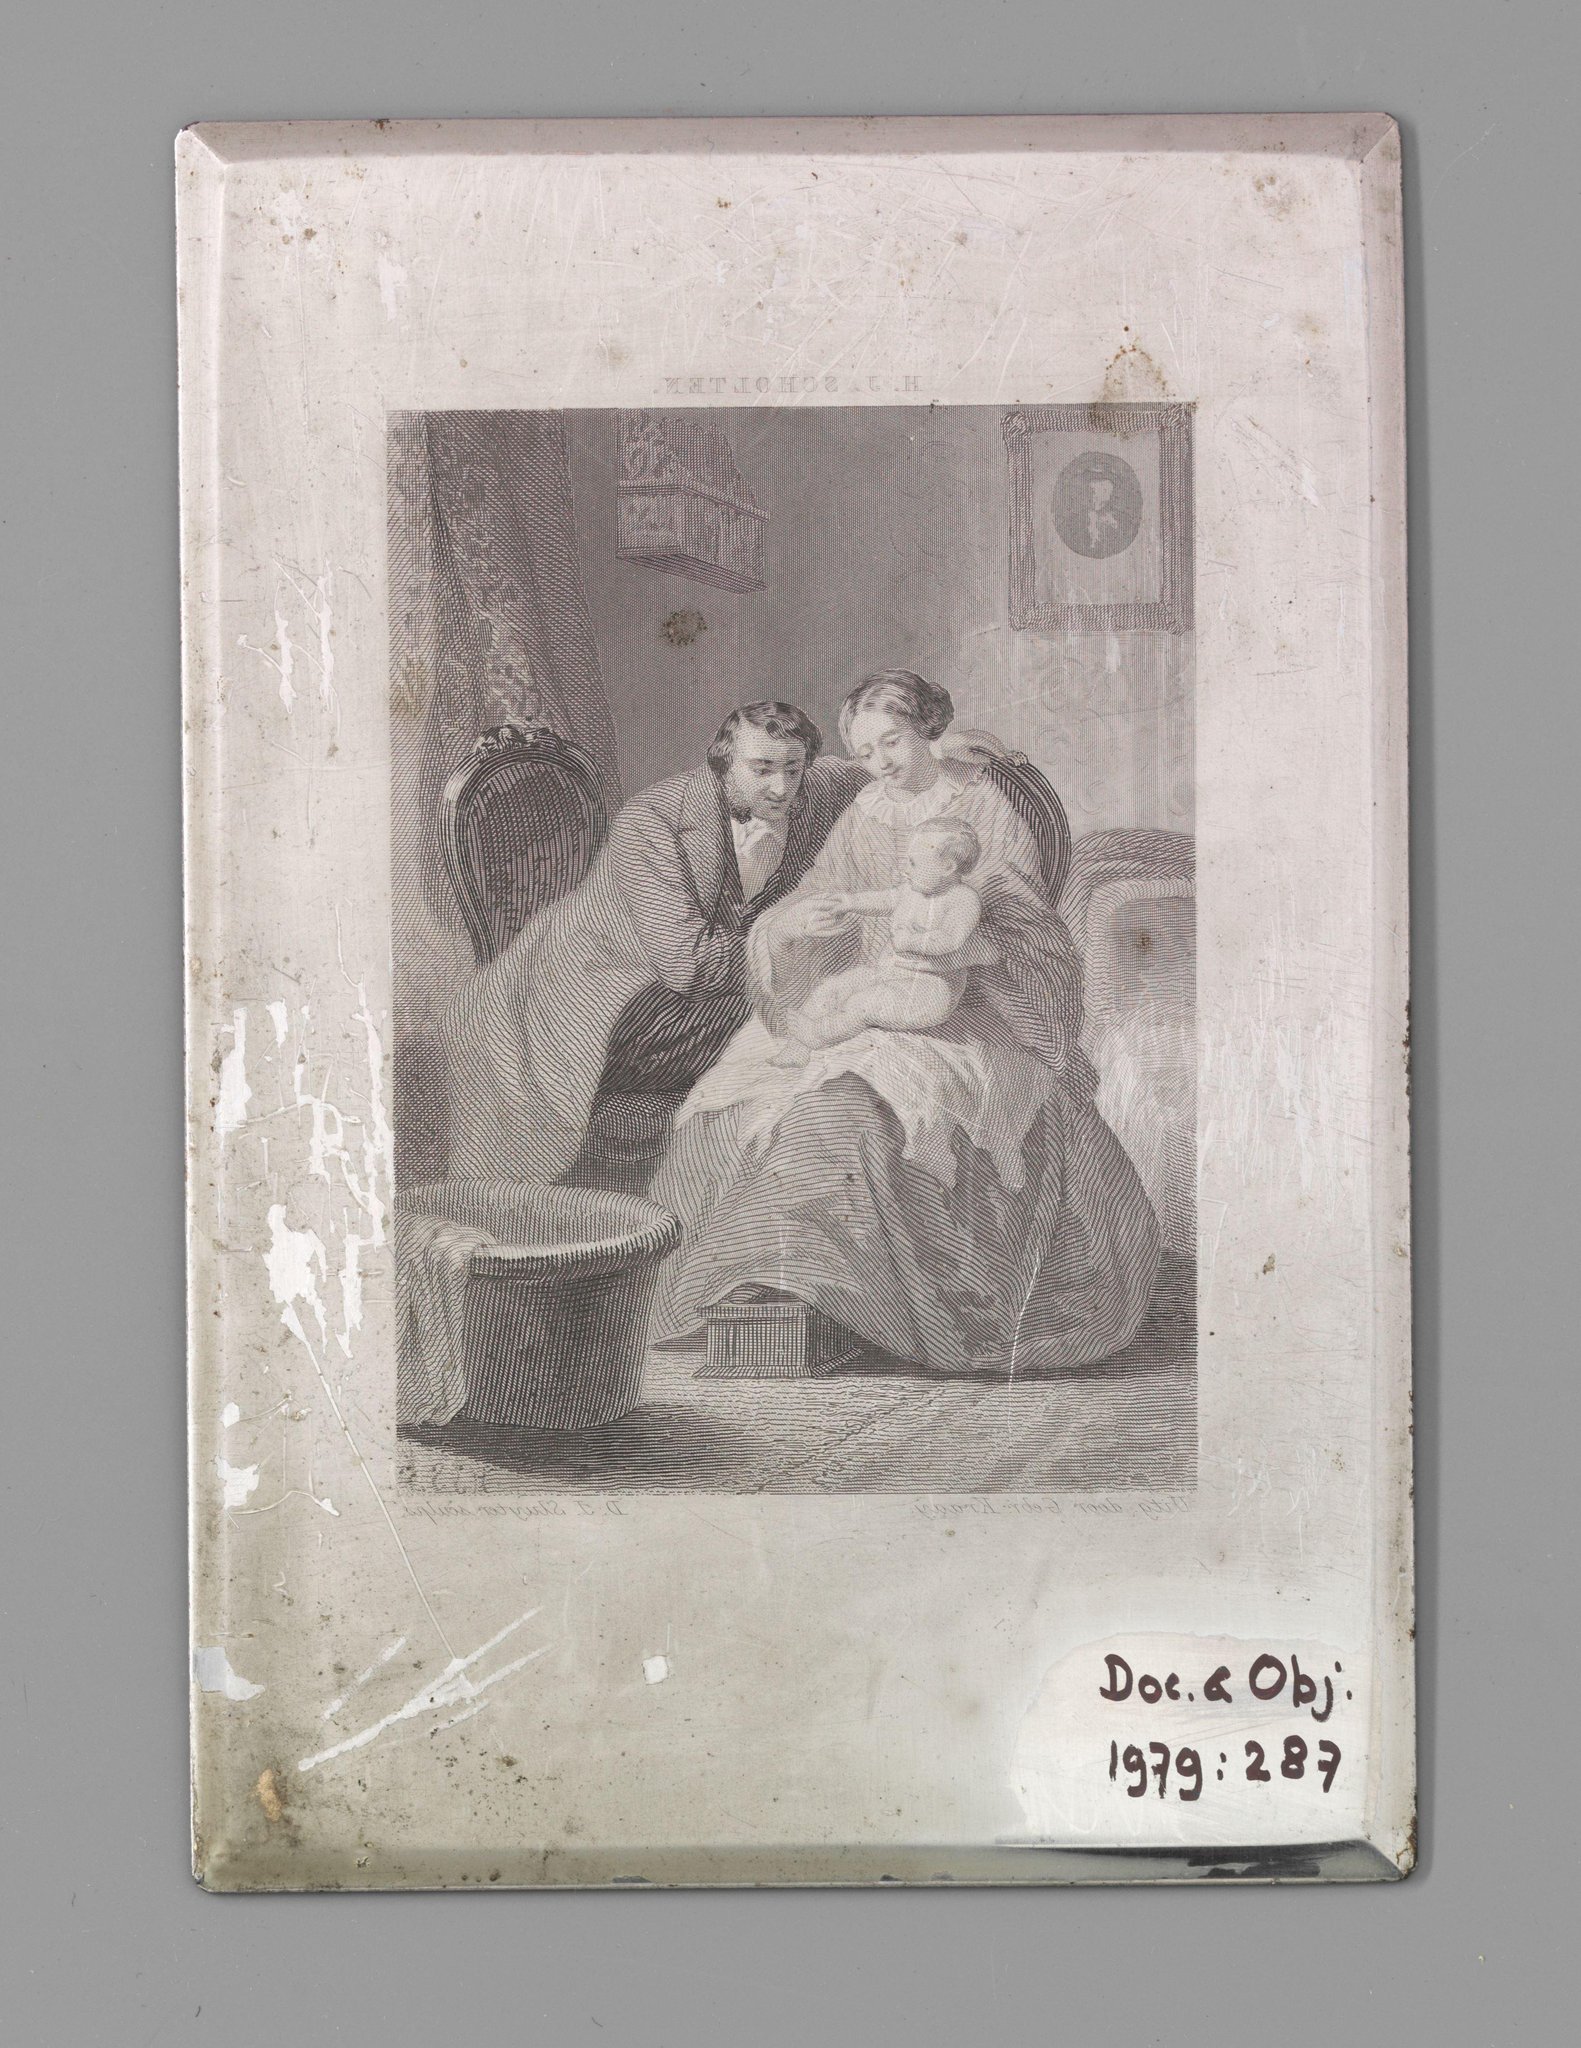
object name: staalplaat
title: Echtpaar met kind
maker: dirk jurriaan sluyter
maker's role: draughtsman, print maker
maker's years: 1811-1886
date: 1834-1870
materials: steel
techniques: engraving